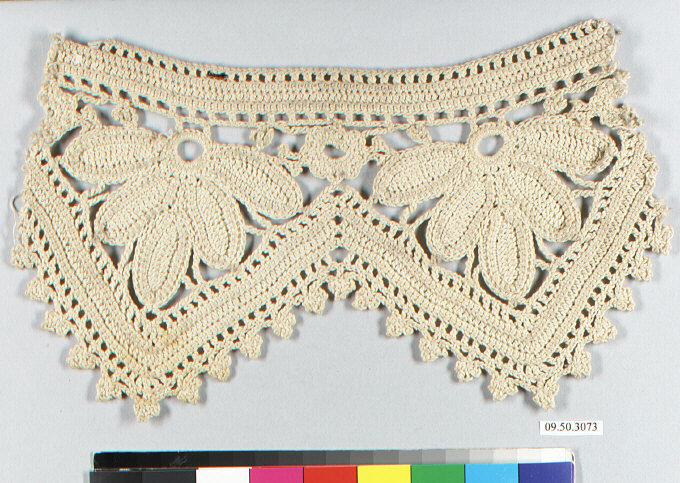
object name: sample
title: Crochet Work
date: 1801-1900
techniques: crochet